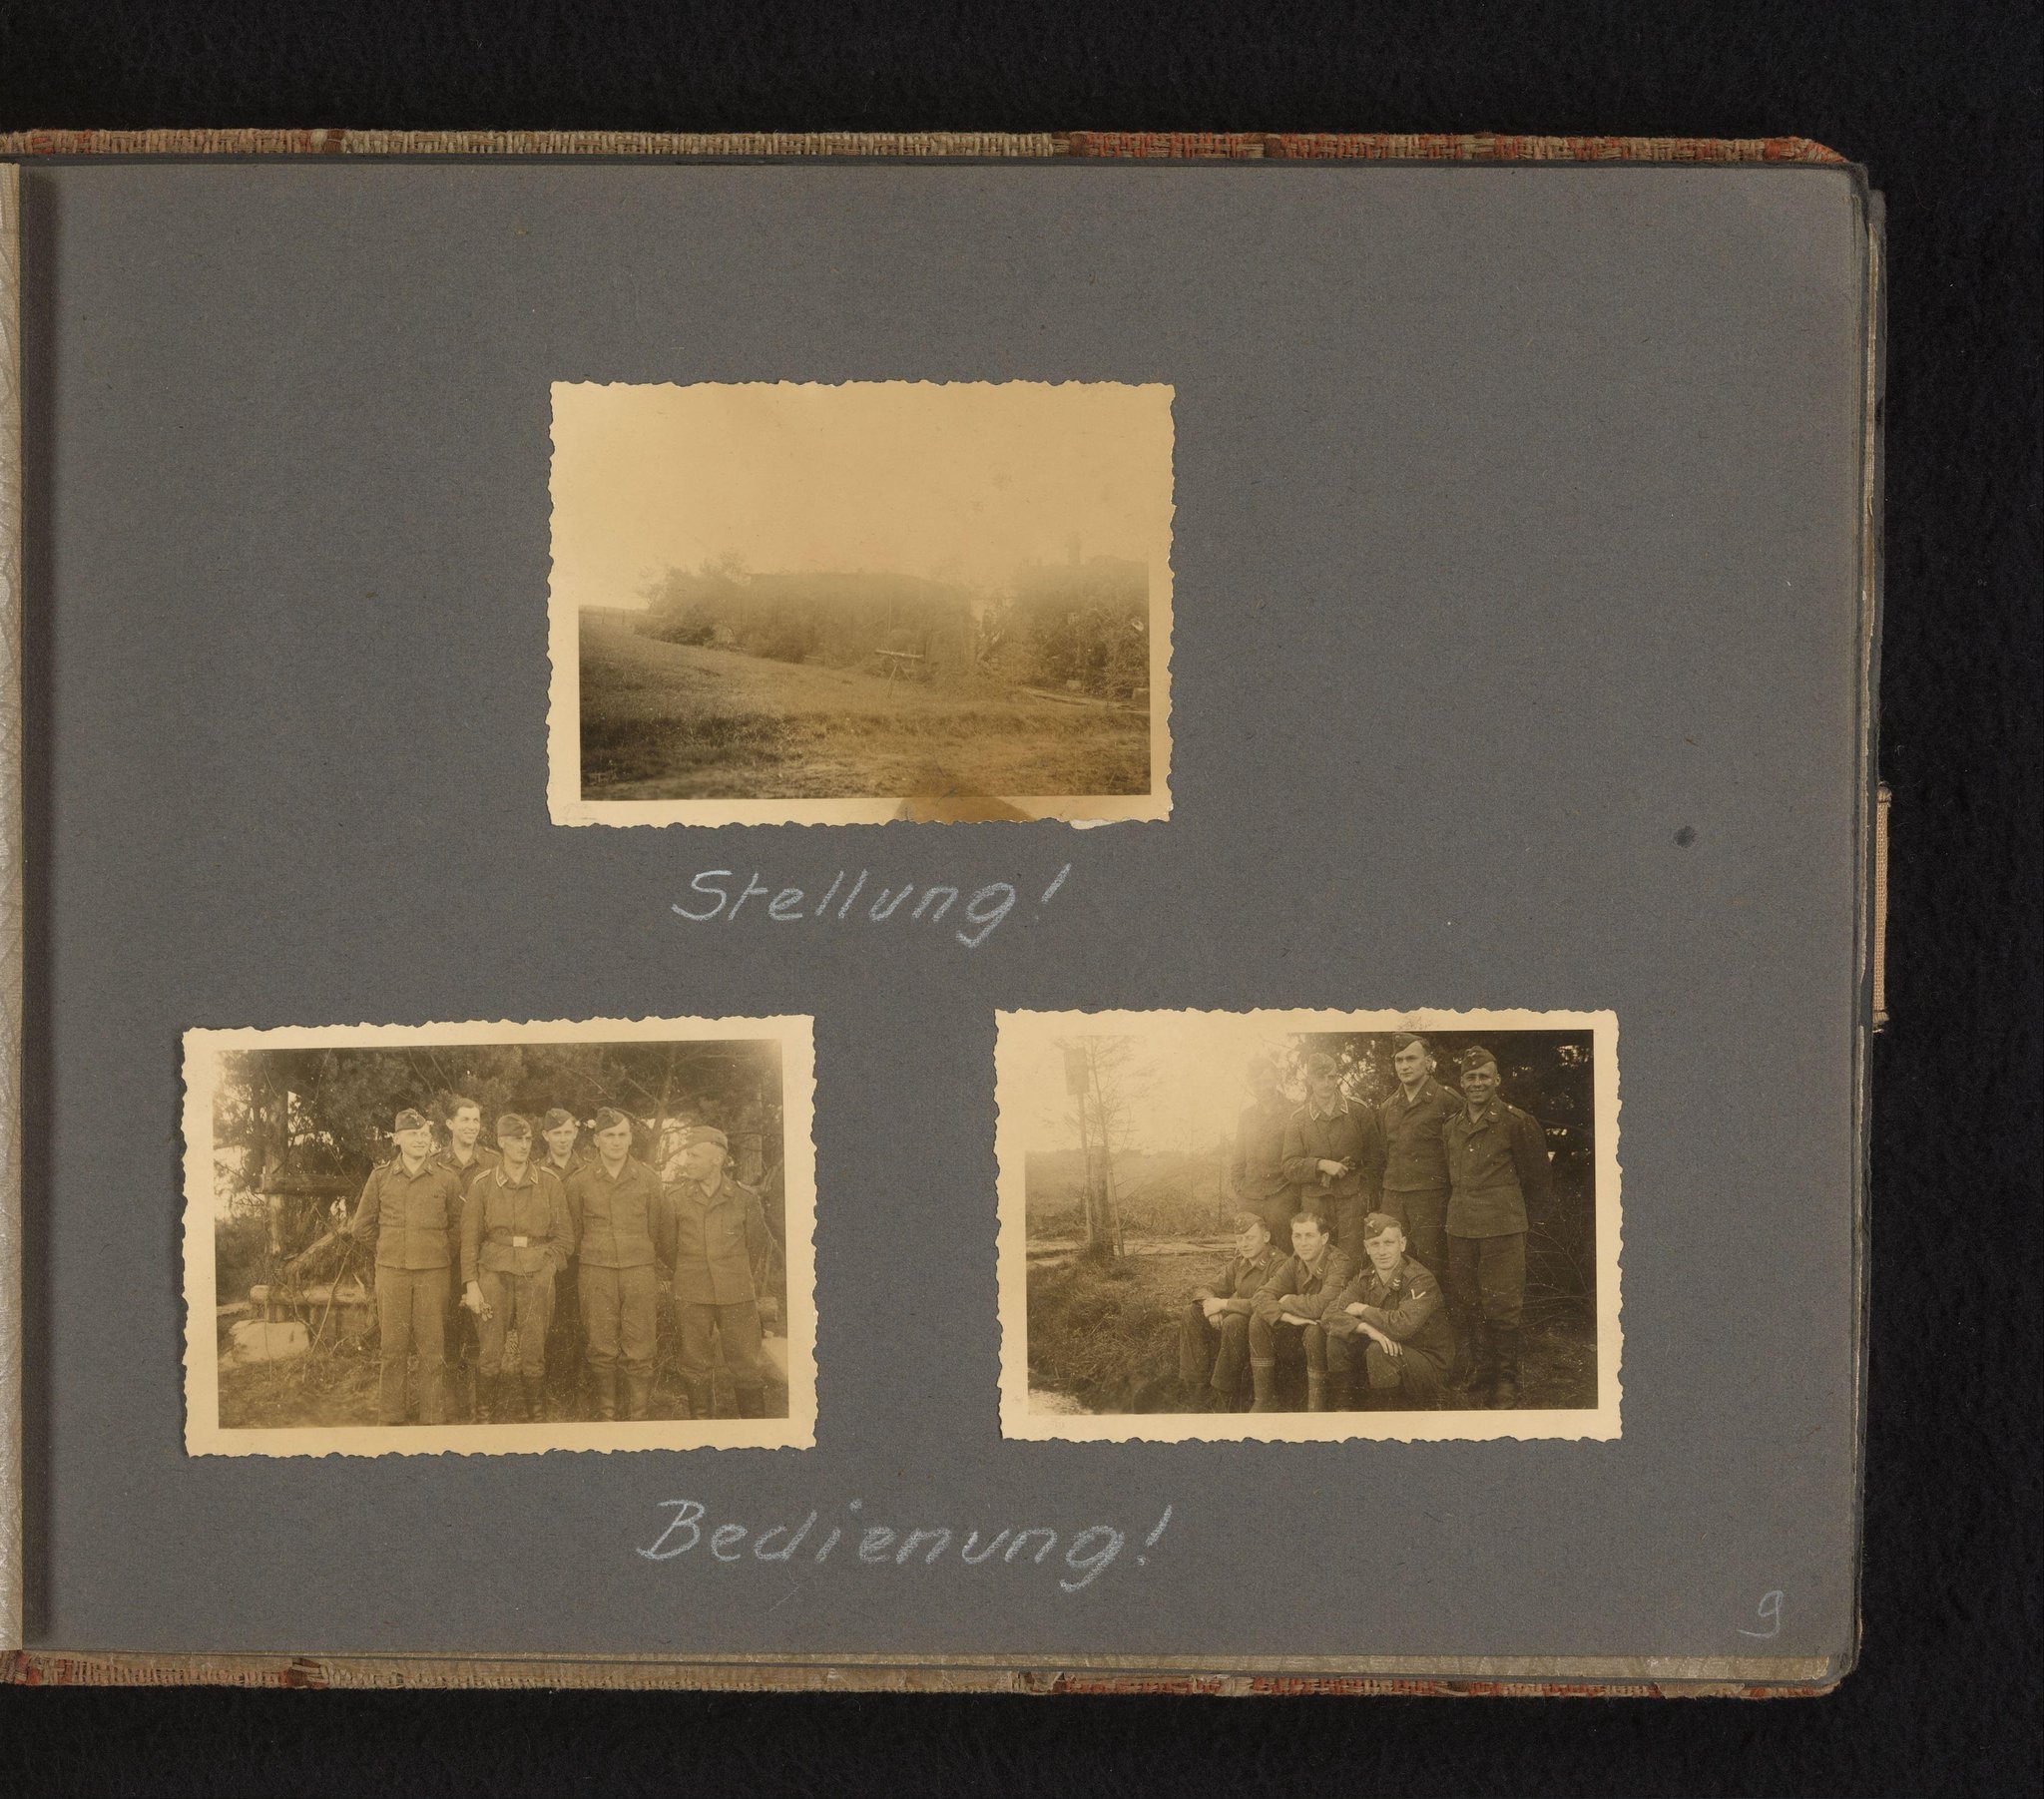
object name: photograph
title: Stellung! Bedienung!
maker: Anonymous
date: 1940-1941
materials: paper, photographic support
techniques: gelatin silver print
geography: netherlands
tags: the company, the unit, the troop ~ military service, division of armed forces (+ artillery), firearms: cannon, netherlands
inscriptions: inscription: ‘Stellung! Bedienung!’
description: Albumblad met drie foto's van een verdekte artilleriestelling en de Duitse soldaten die het bedienen. Onderdeel van het fotoalbum 'Kriegszeit in Holland' over de diensttijd in Nederland van Hans Heinemann van een Flak Regiment van de Luftverteidigungskommando van de Luftwaffe.